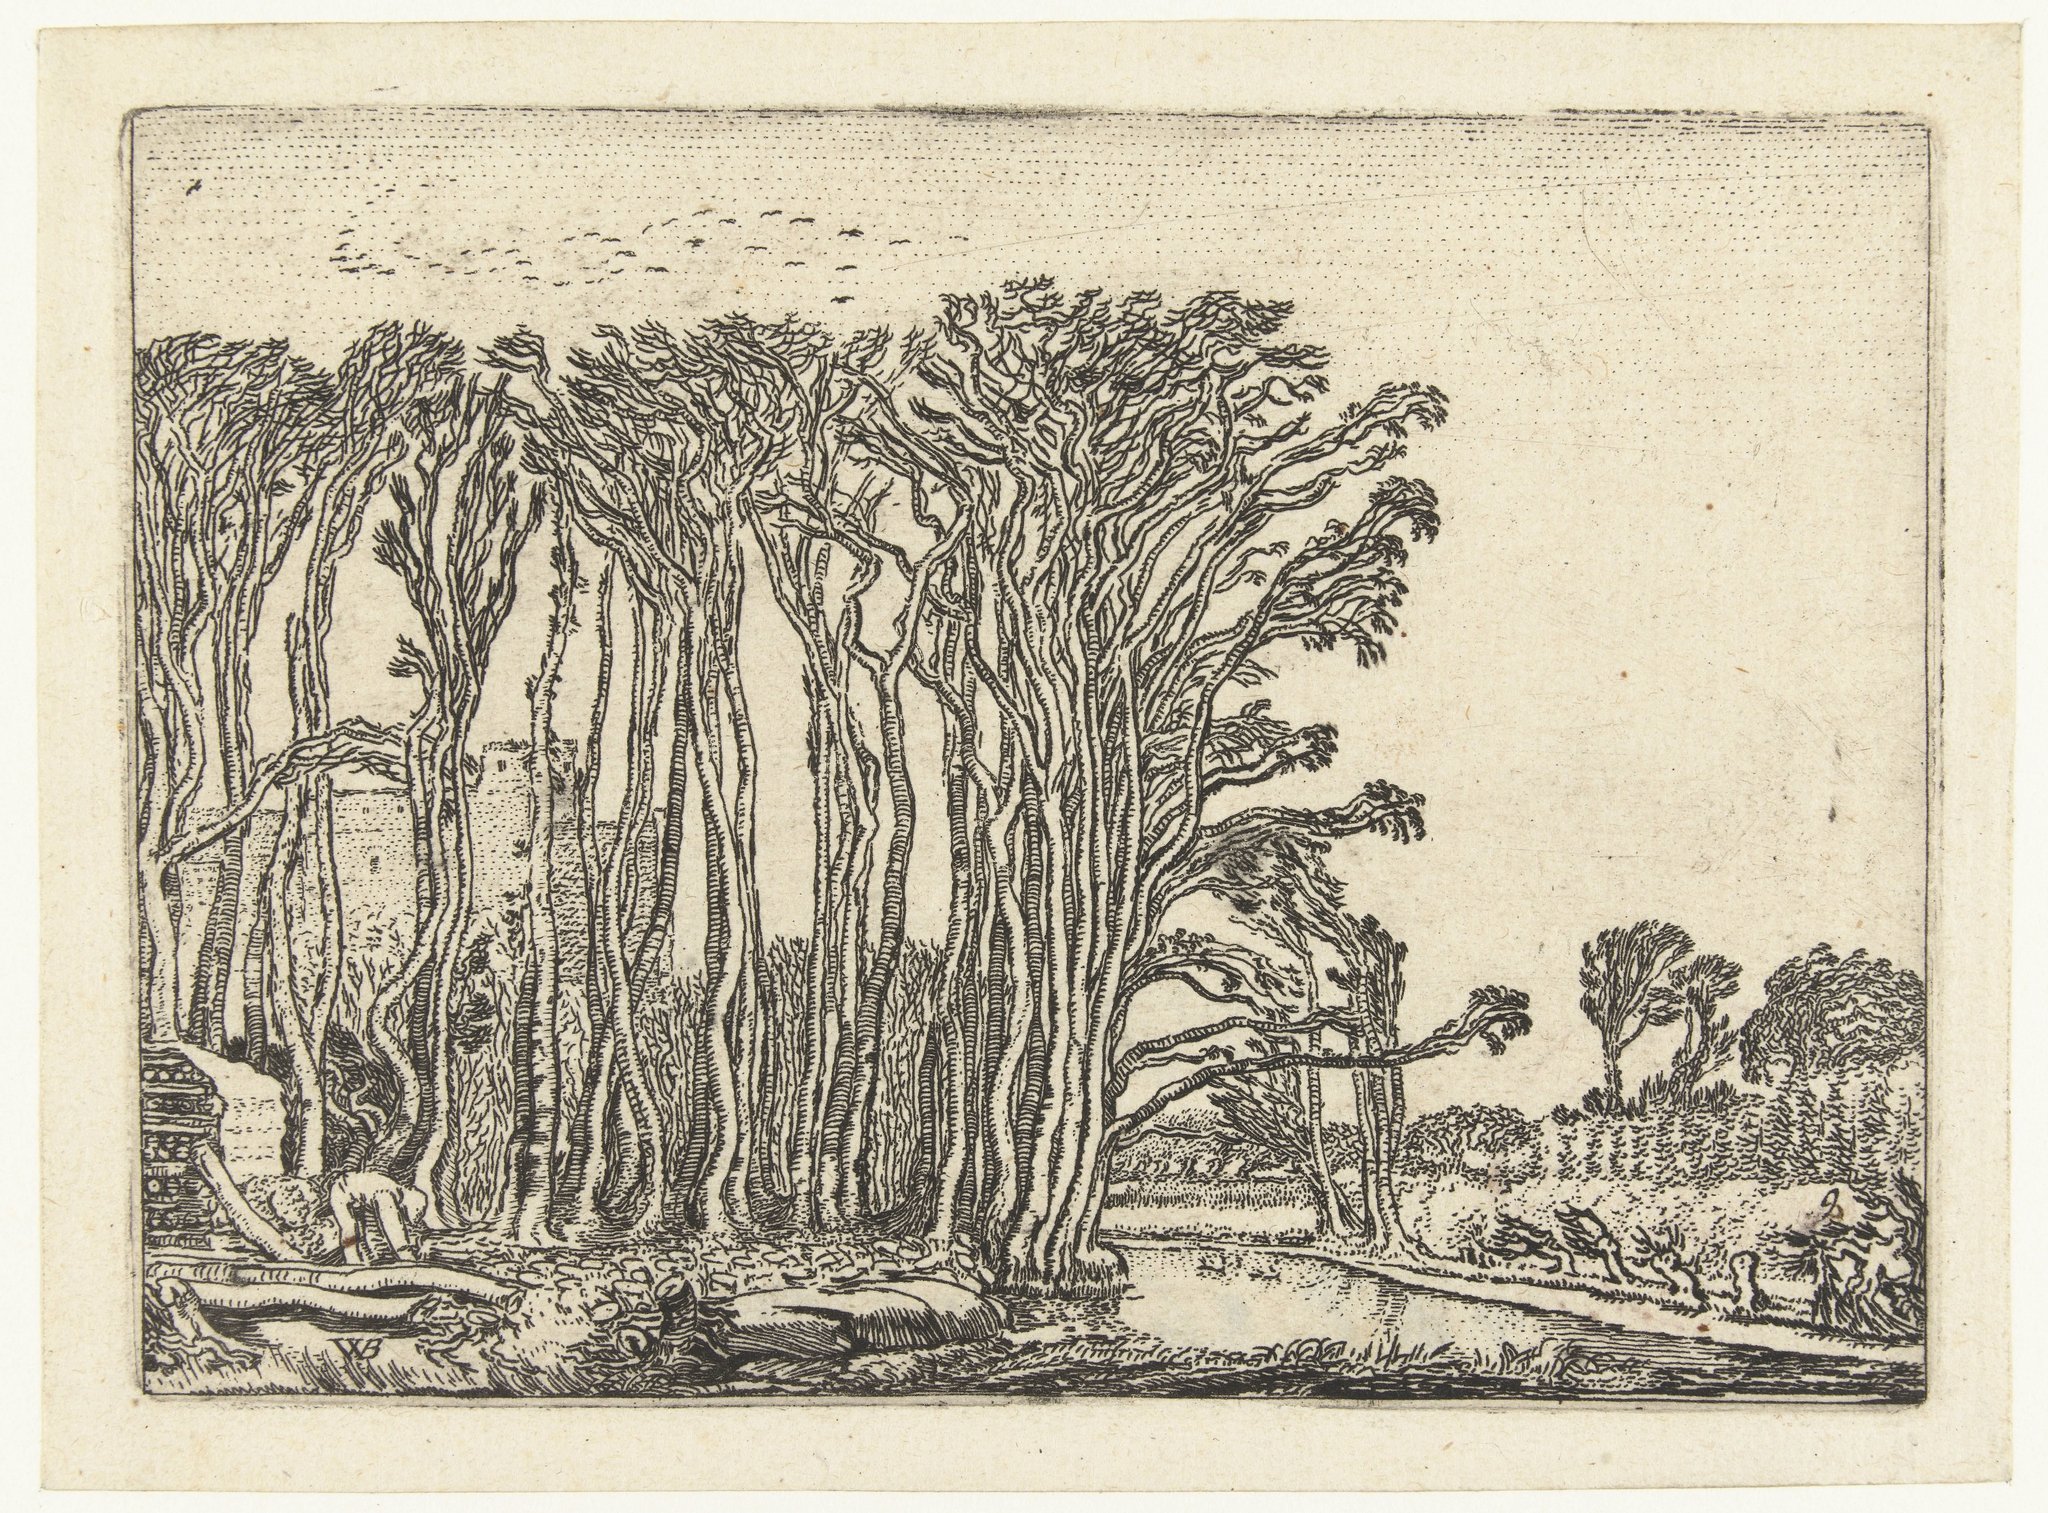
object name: print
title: Landschap met kale bomen aan een water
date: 1621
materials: paper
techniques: etching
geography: amsterdam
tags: trees, woodgathering, woodgatherer, water course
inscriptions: collector's mark: Lugt 240